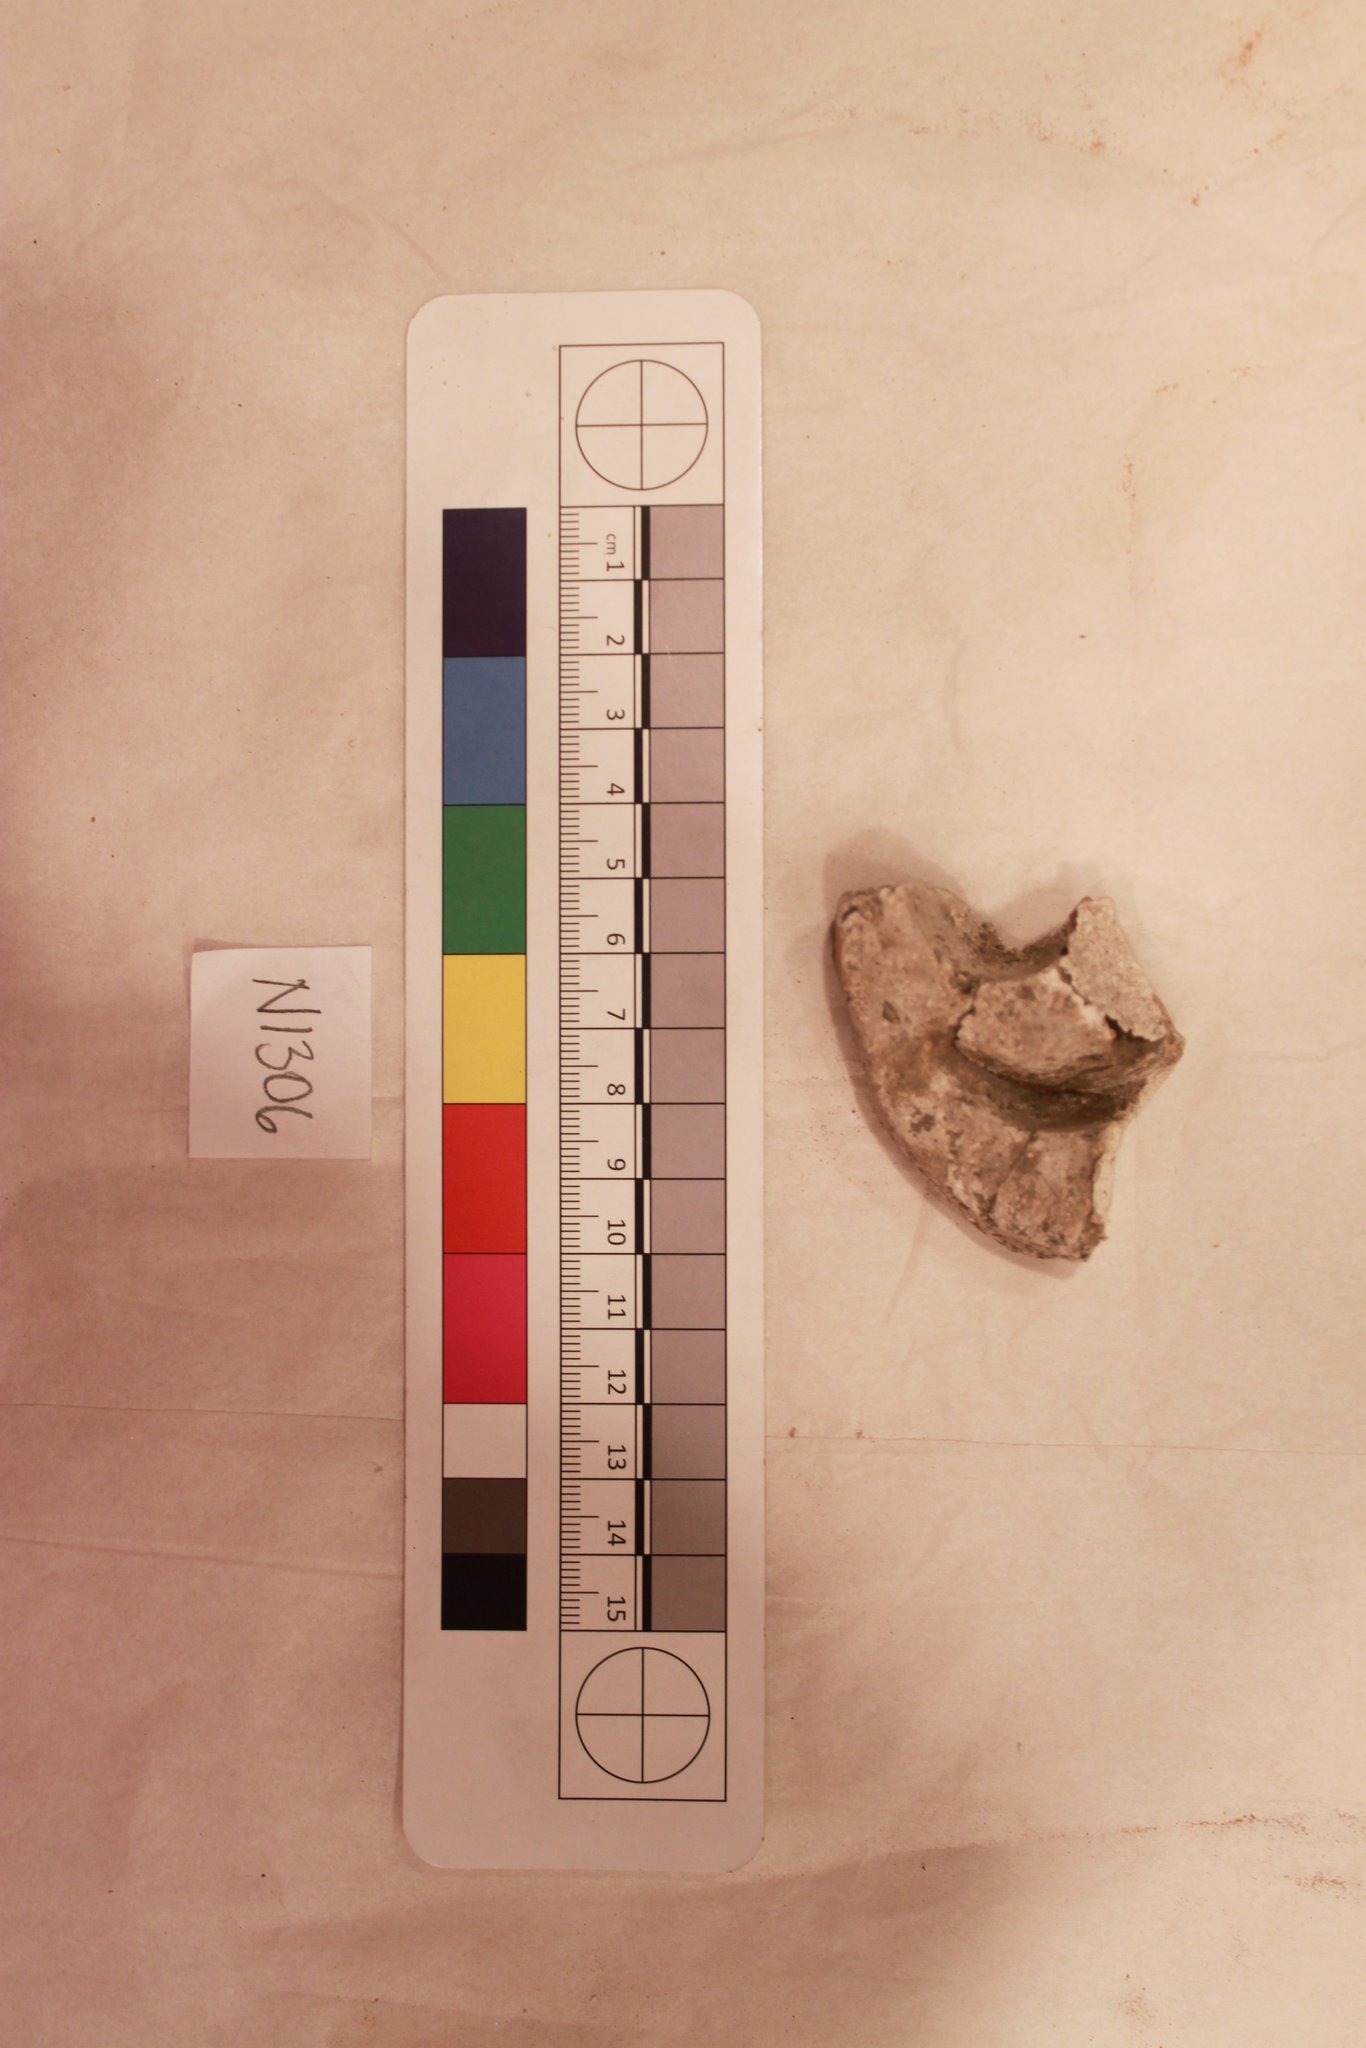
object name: fragment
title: Stucco Fragment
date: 701-1200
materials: plaster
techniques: carving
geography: iran